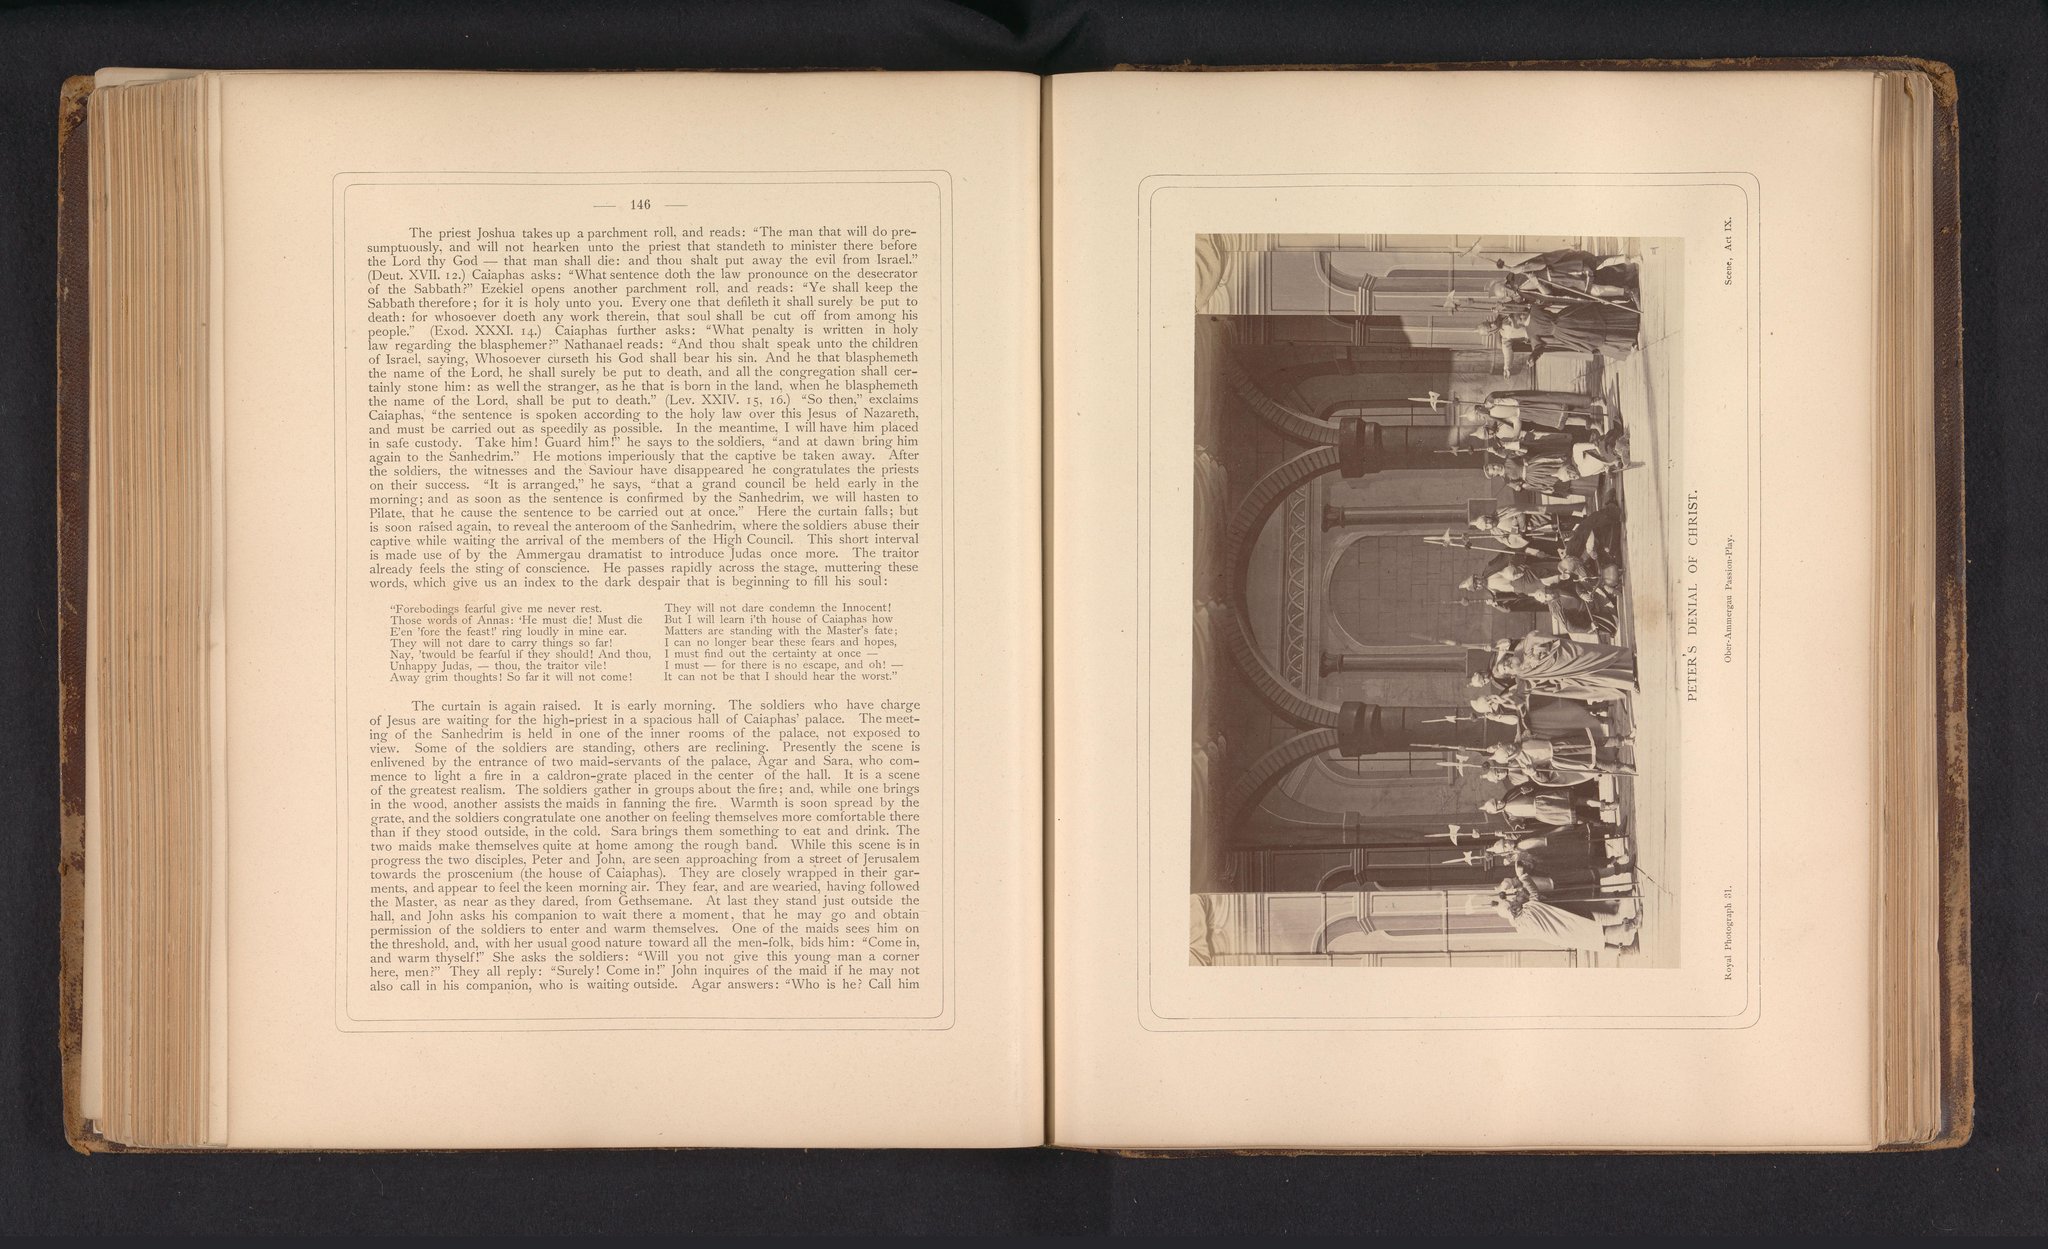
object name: page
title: Peter's denial of Christ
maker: joseph albert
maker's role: printer, publisher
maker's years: 1825-1886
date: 1868-1873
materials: photographic support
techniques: albumen print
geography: oberammergau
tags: group of actors, troupe; actors on the stage, peter denies christ, usually before a girl-servant and some soldiers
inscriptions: number: ‘Royal Photograph 31.’